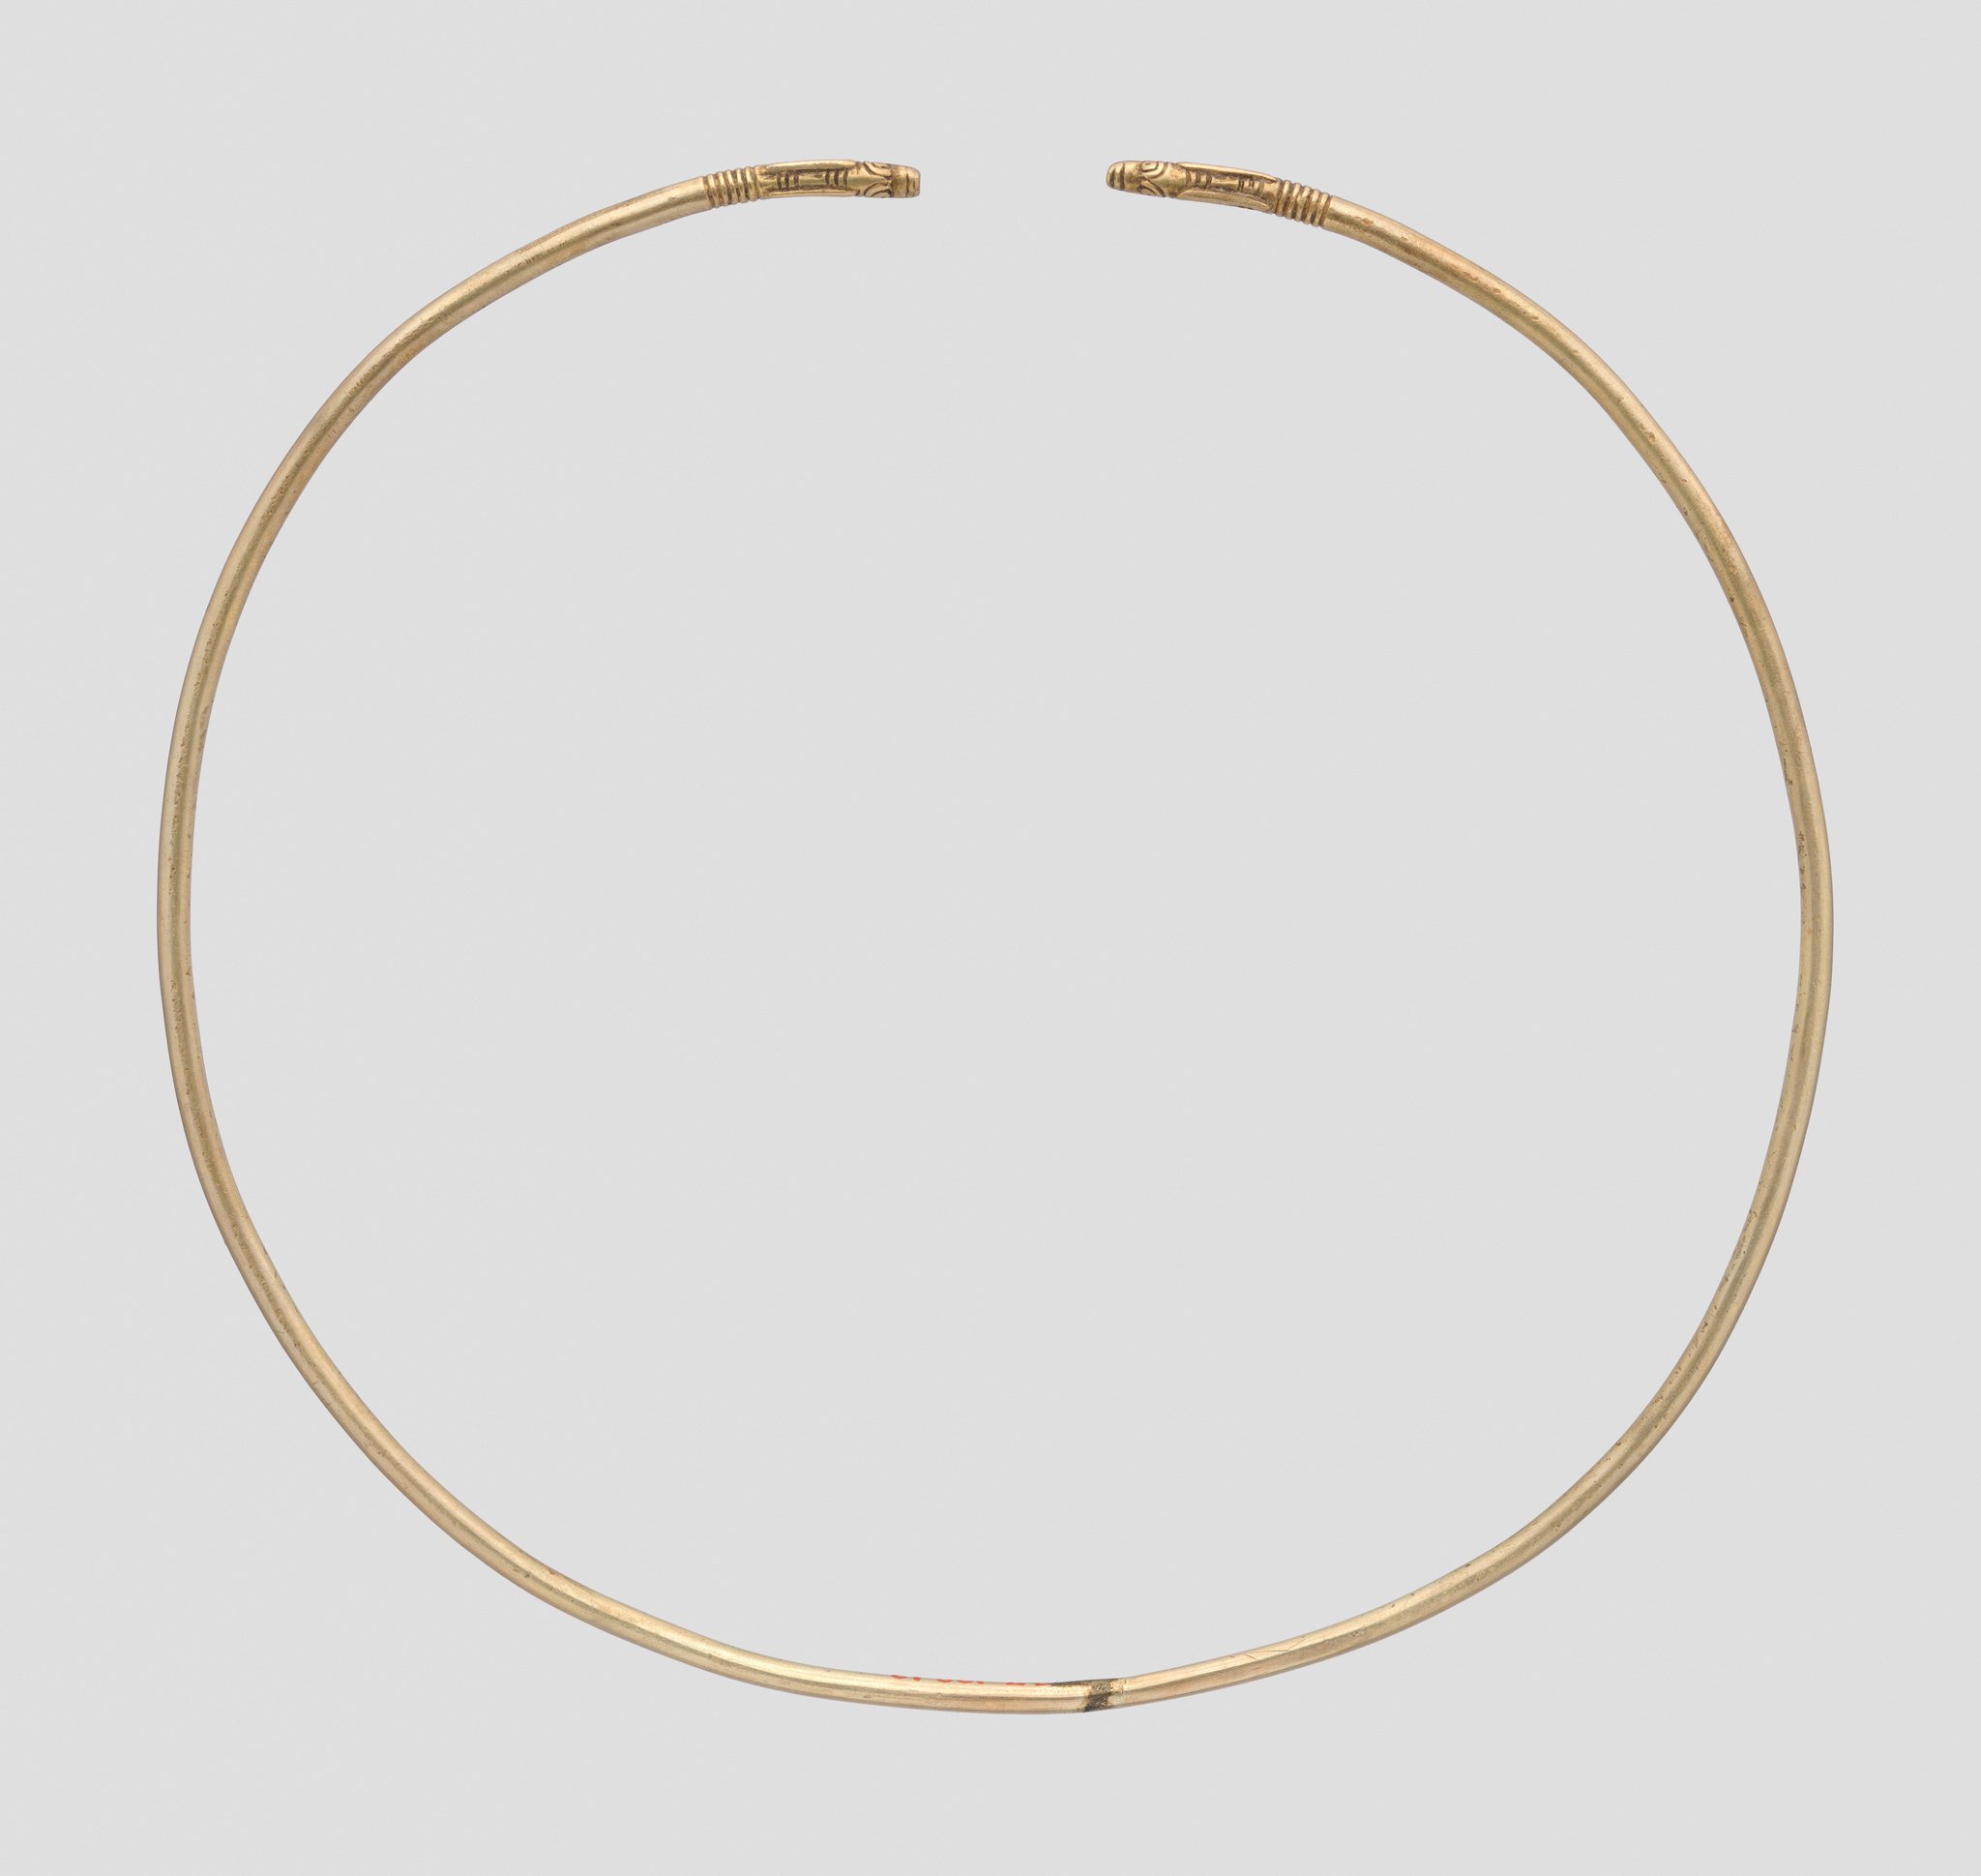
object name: torque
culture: scythian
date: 1000-1 BCE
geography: eurasian steppes